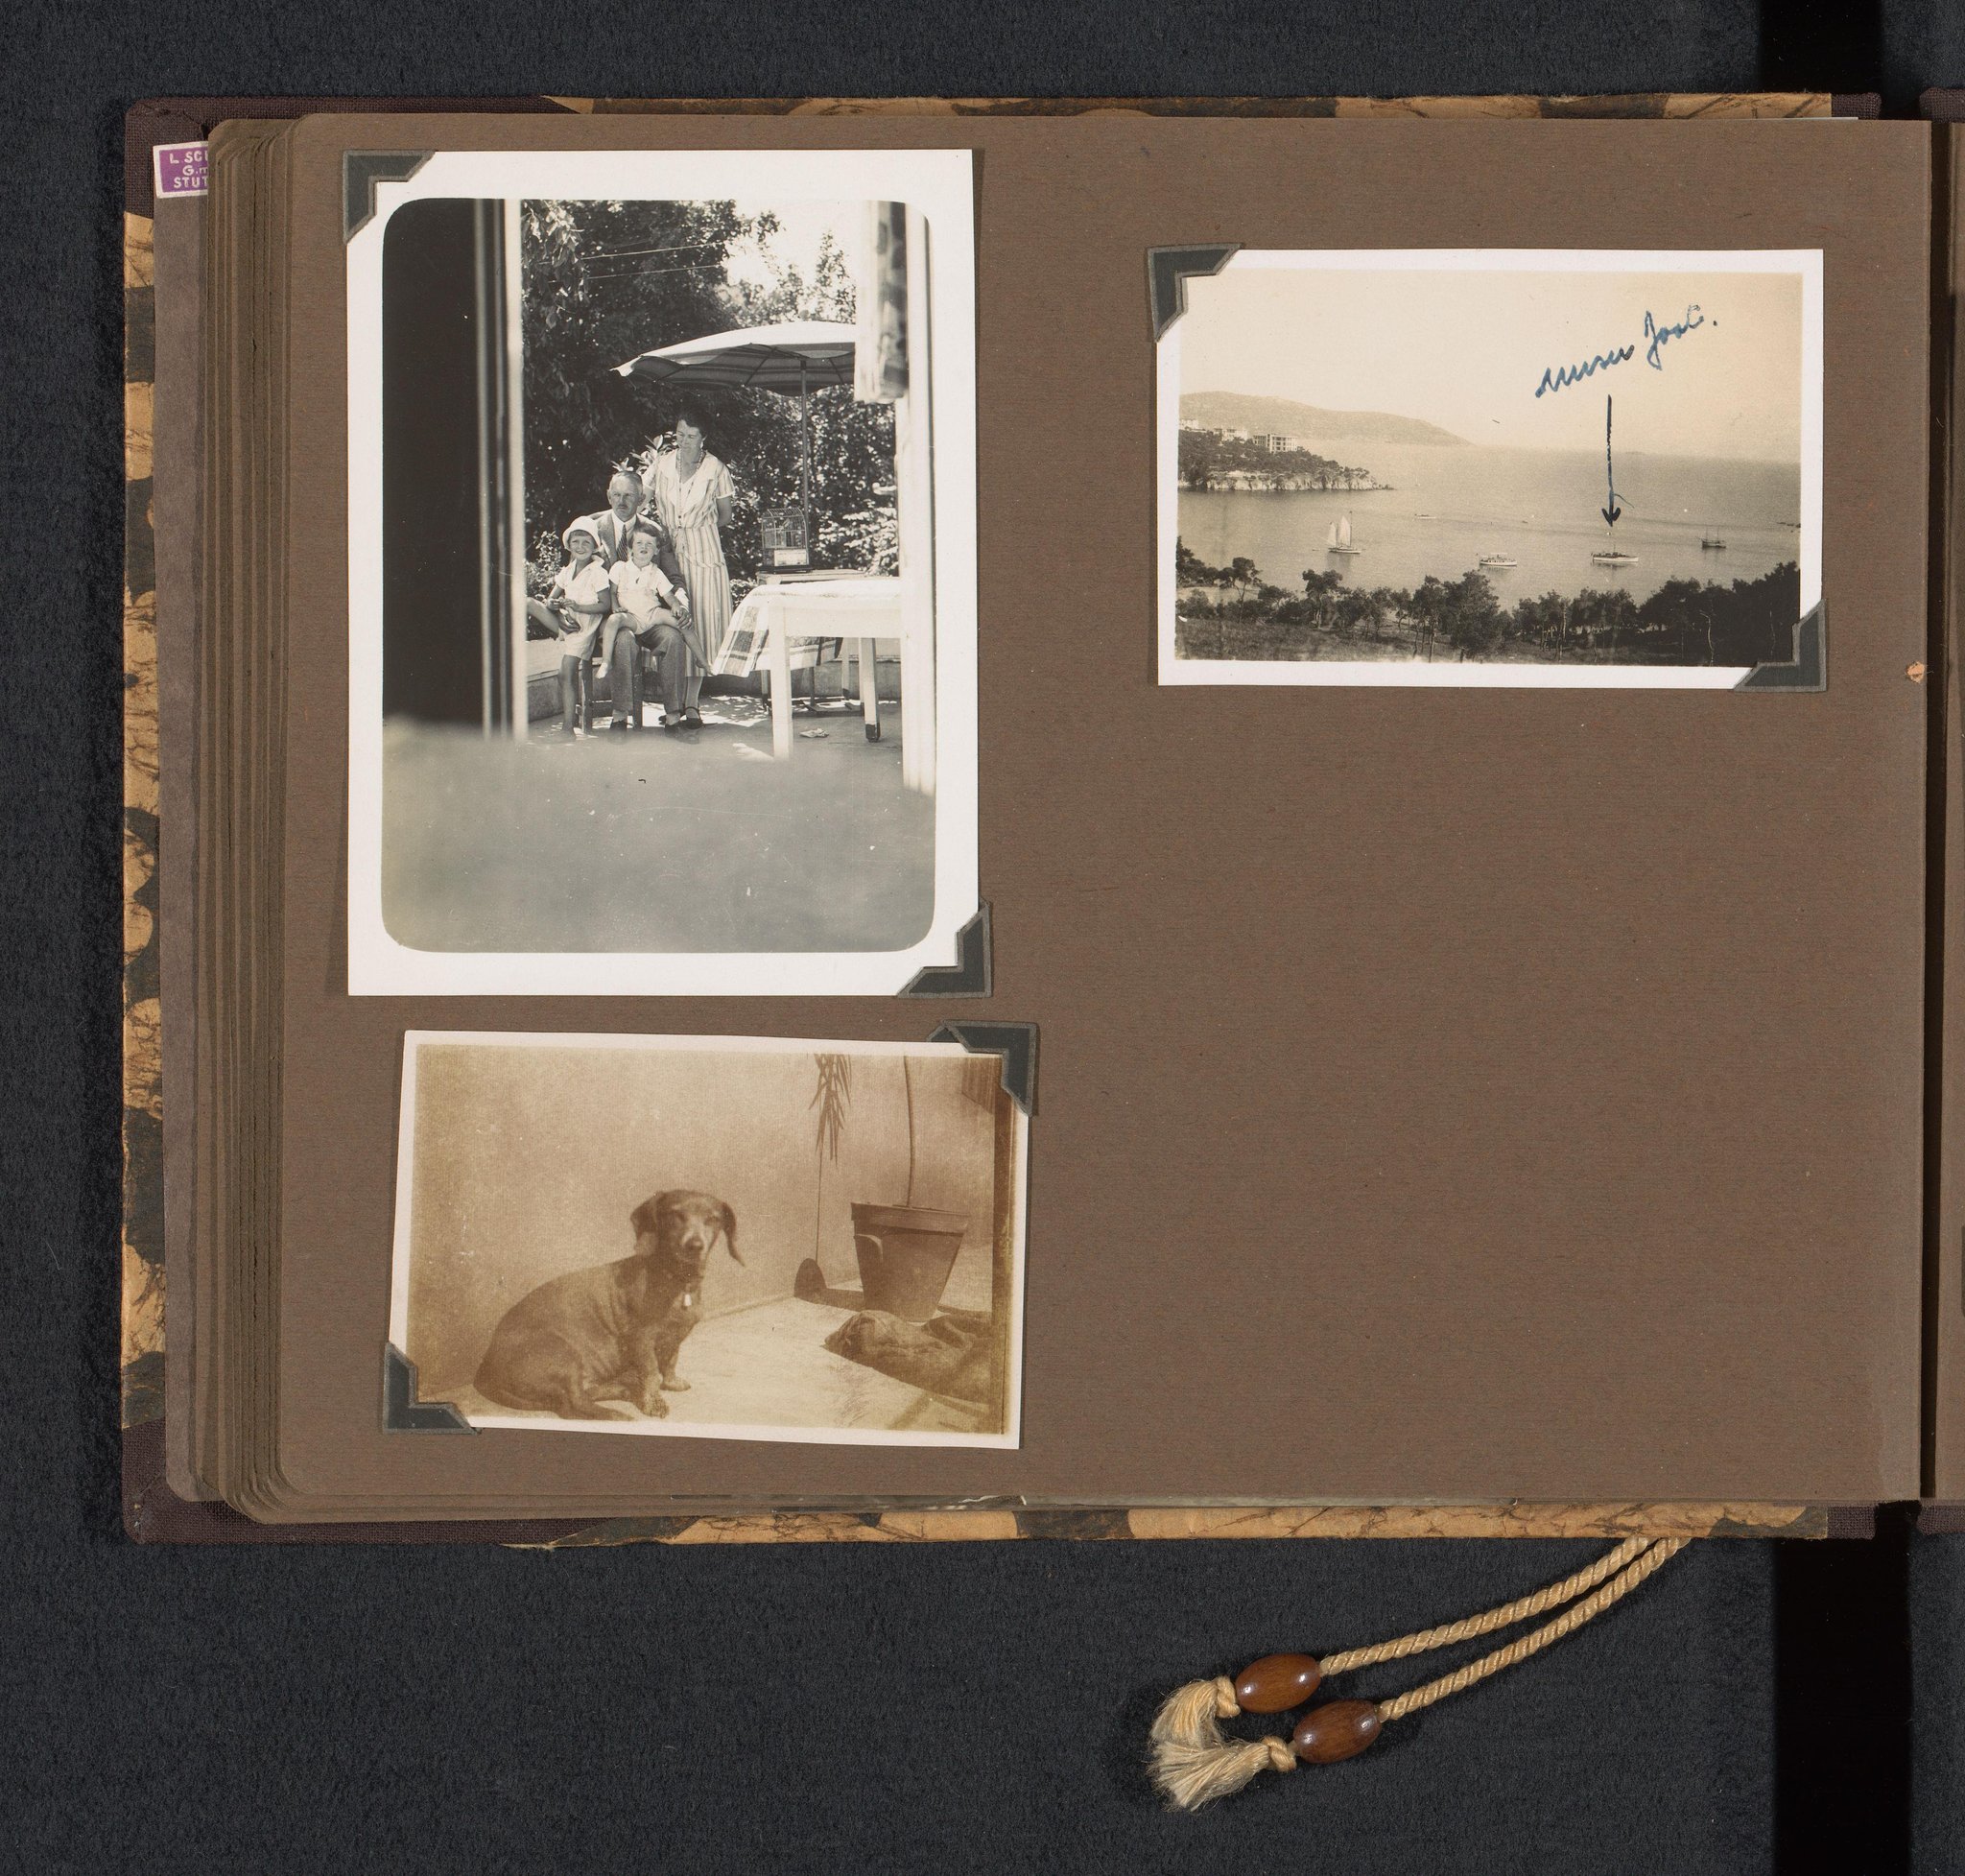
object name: photograph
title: Onbekende personen, hond en boten, mogelijk tijdens rondreis van Eugen Wachenheimer en Else Wachenheimer-Moos door Bulgarije, 1926-1927, Bulgarije?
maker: else wachenheimer-moos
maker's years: 1895-1944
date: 1926-1927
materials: paper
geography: bulgaria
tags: bulgarije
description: Albumblad bevat drie foto's van onbekende personen. Afkomstig uit album half formaat, kartonomslag met koordbinding en lichte veelvormige vormen op voorzijde.